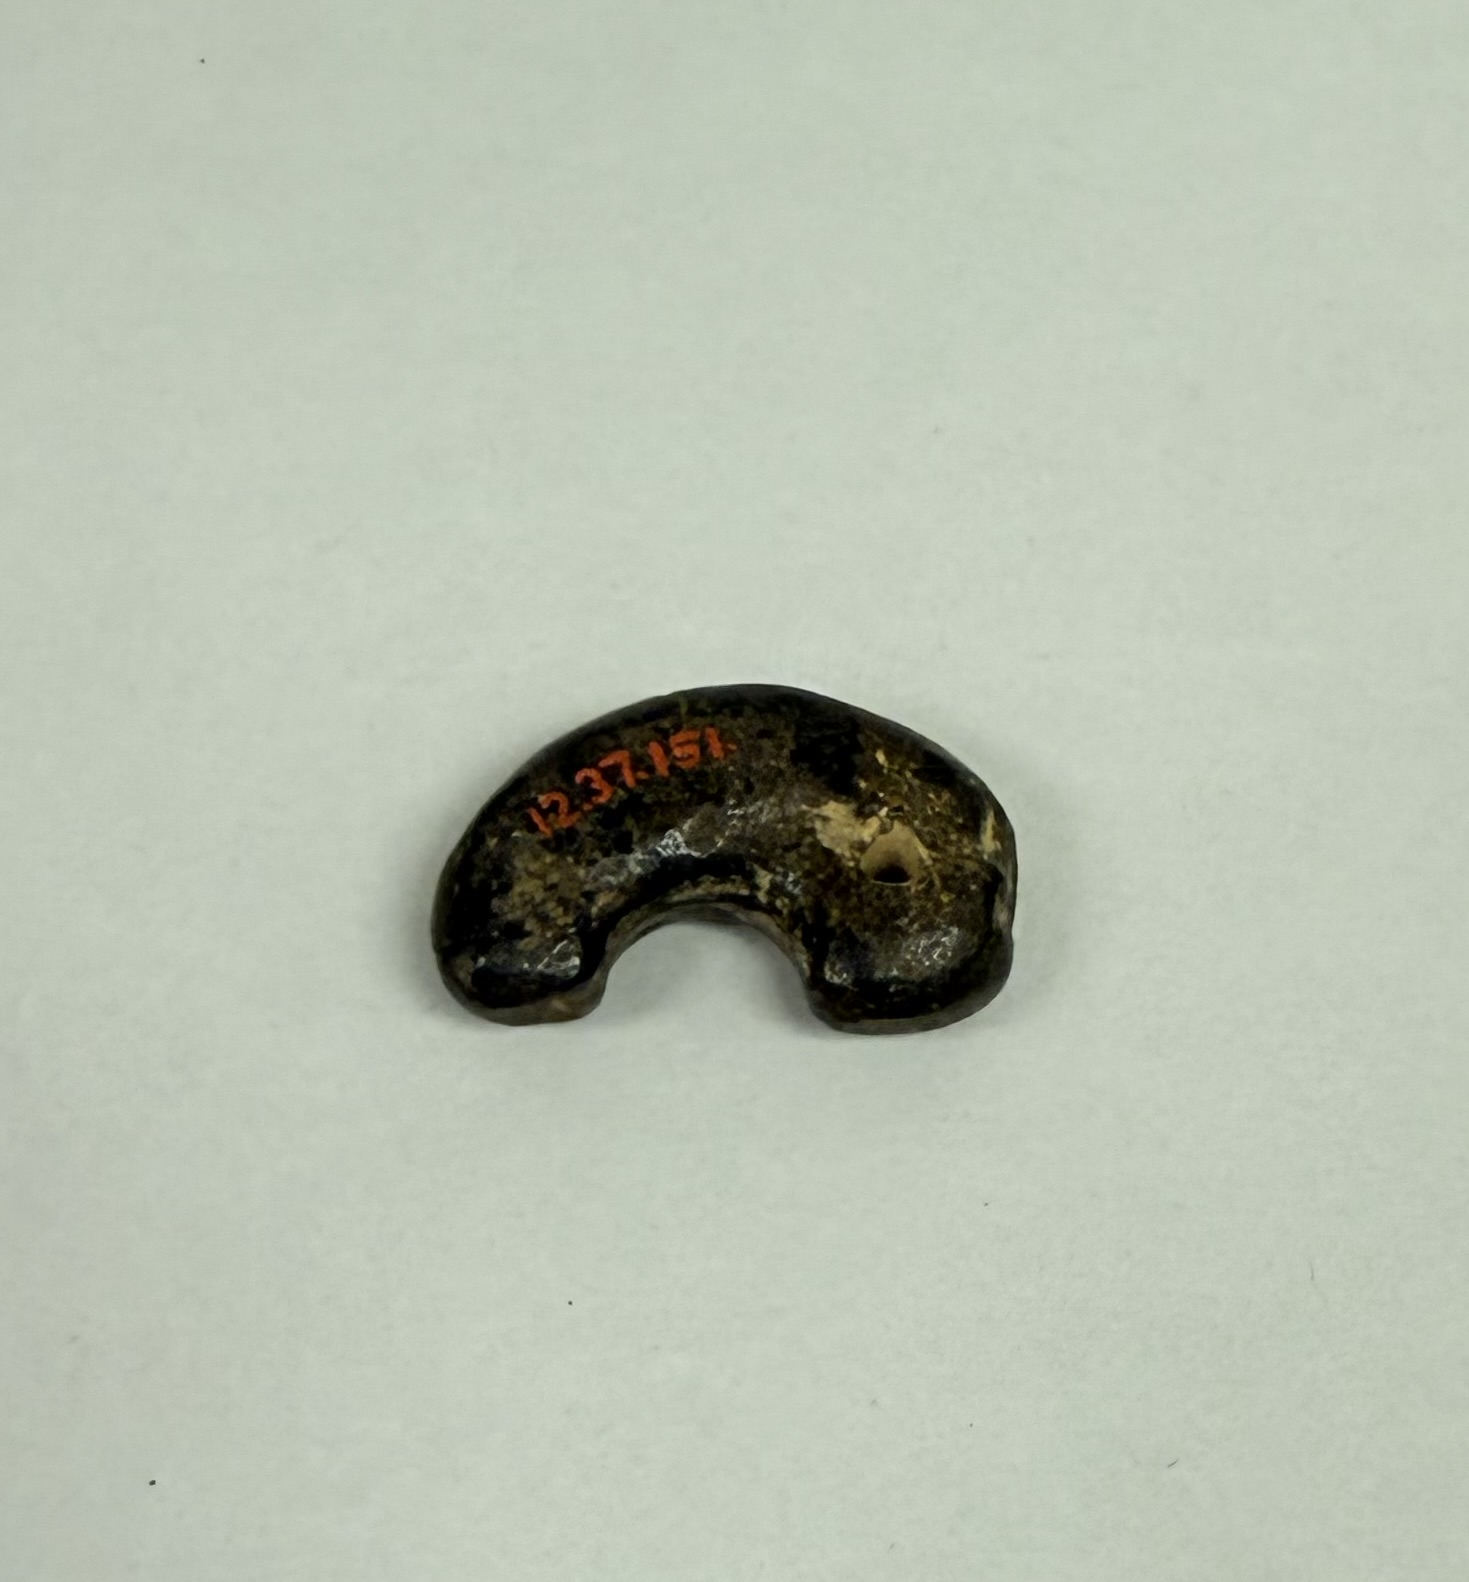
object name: jewel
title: Tiger Claw Jewel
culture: japanese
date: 501-600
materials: stone